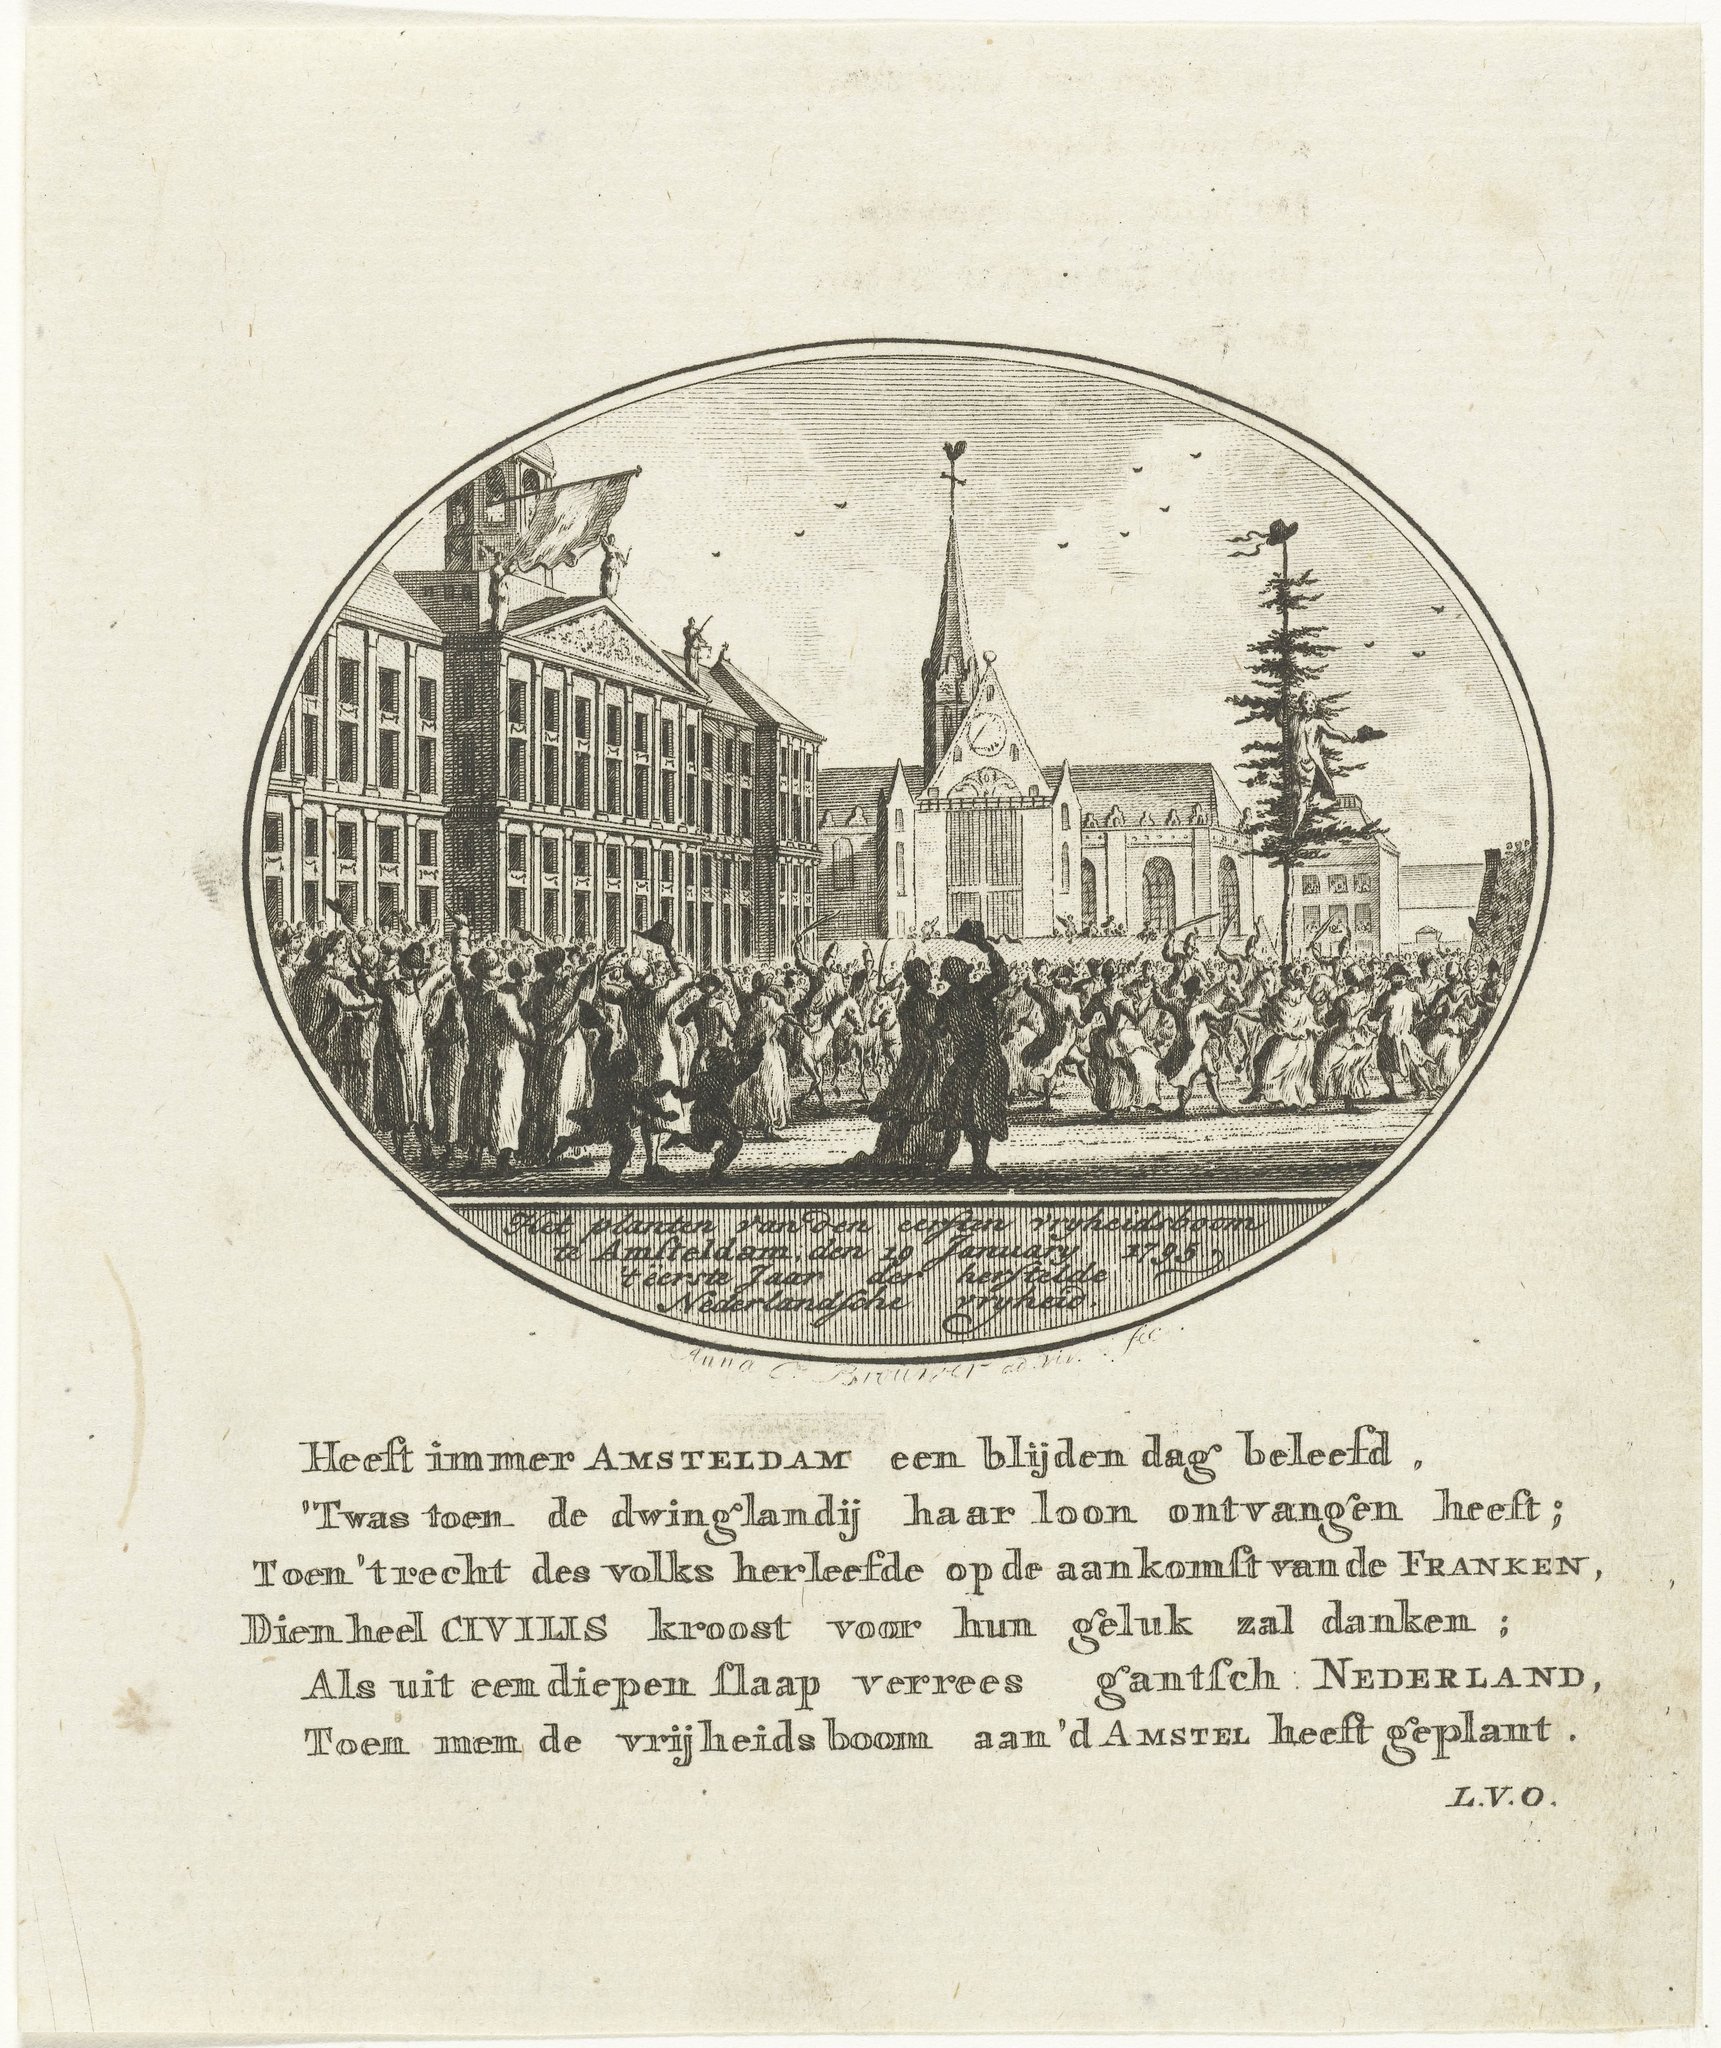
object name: print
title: Vrijheidsfeest in Amsterdam 19 januari 1795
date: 1795-1797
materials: paper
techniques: etching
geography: amsterdam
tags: amsterdam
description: Op de Dam voor het stadhuis zetten burgers een vrijheidsboom op. Het hele plein staat vol met mensen, een jonge man is in de boom geklommen. Onder de voorstelling een gedicht van Lieve van Ollefen over de aankomst van de Fransen in Amsterdam.